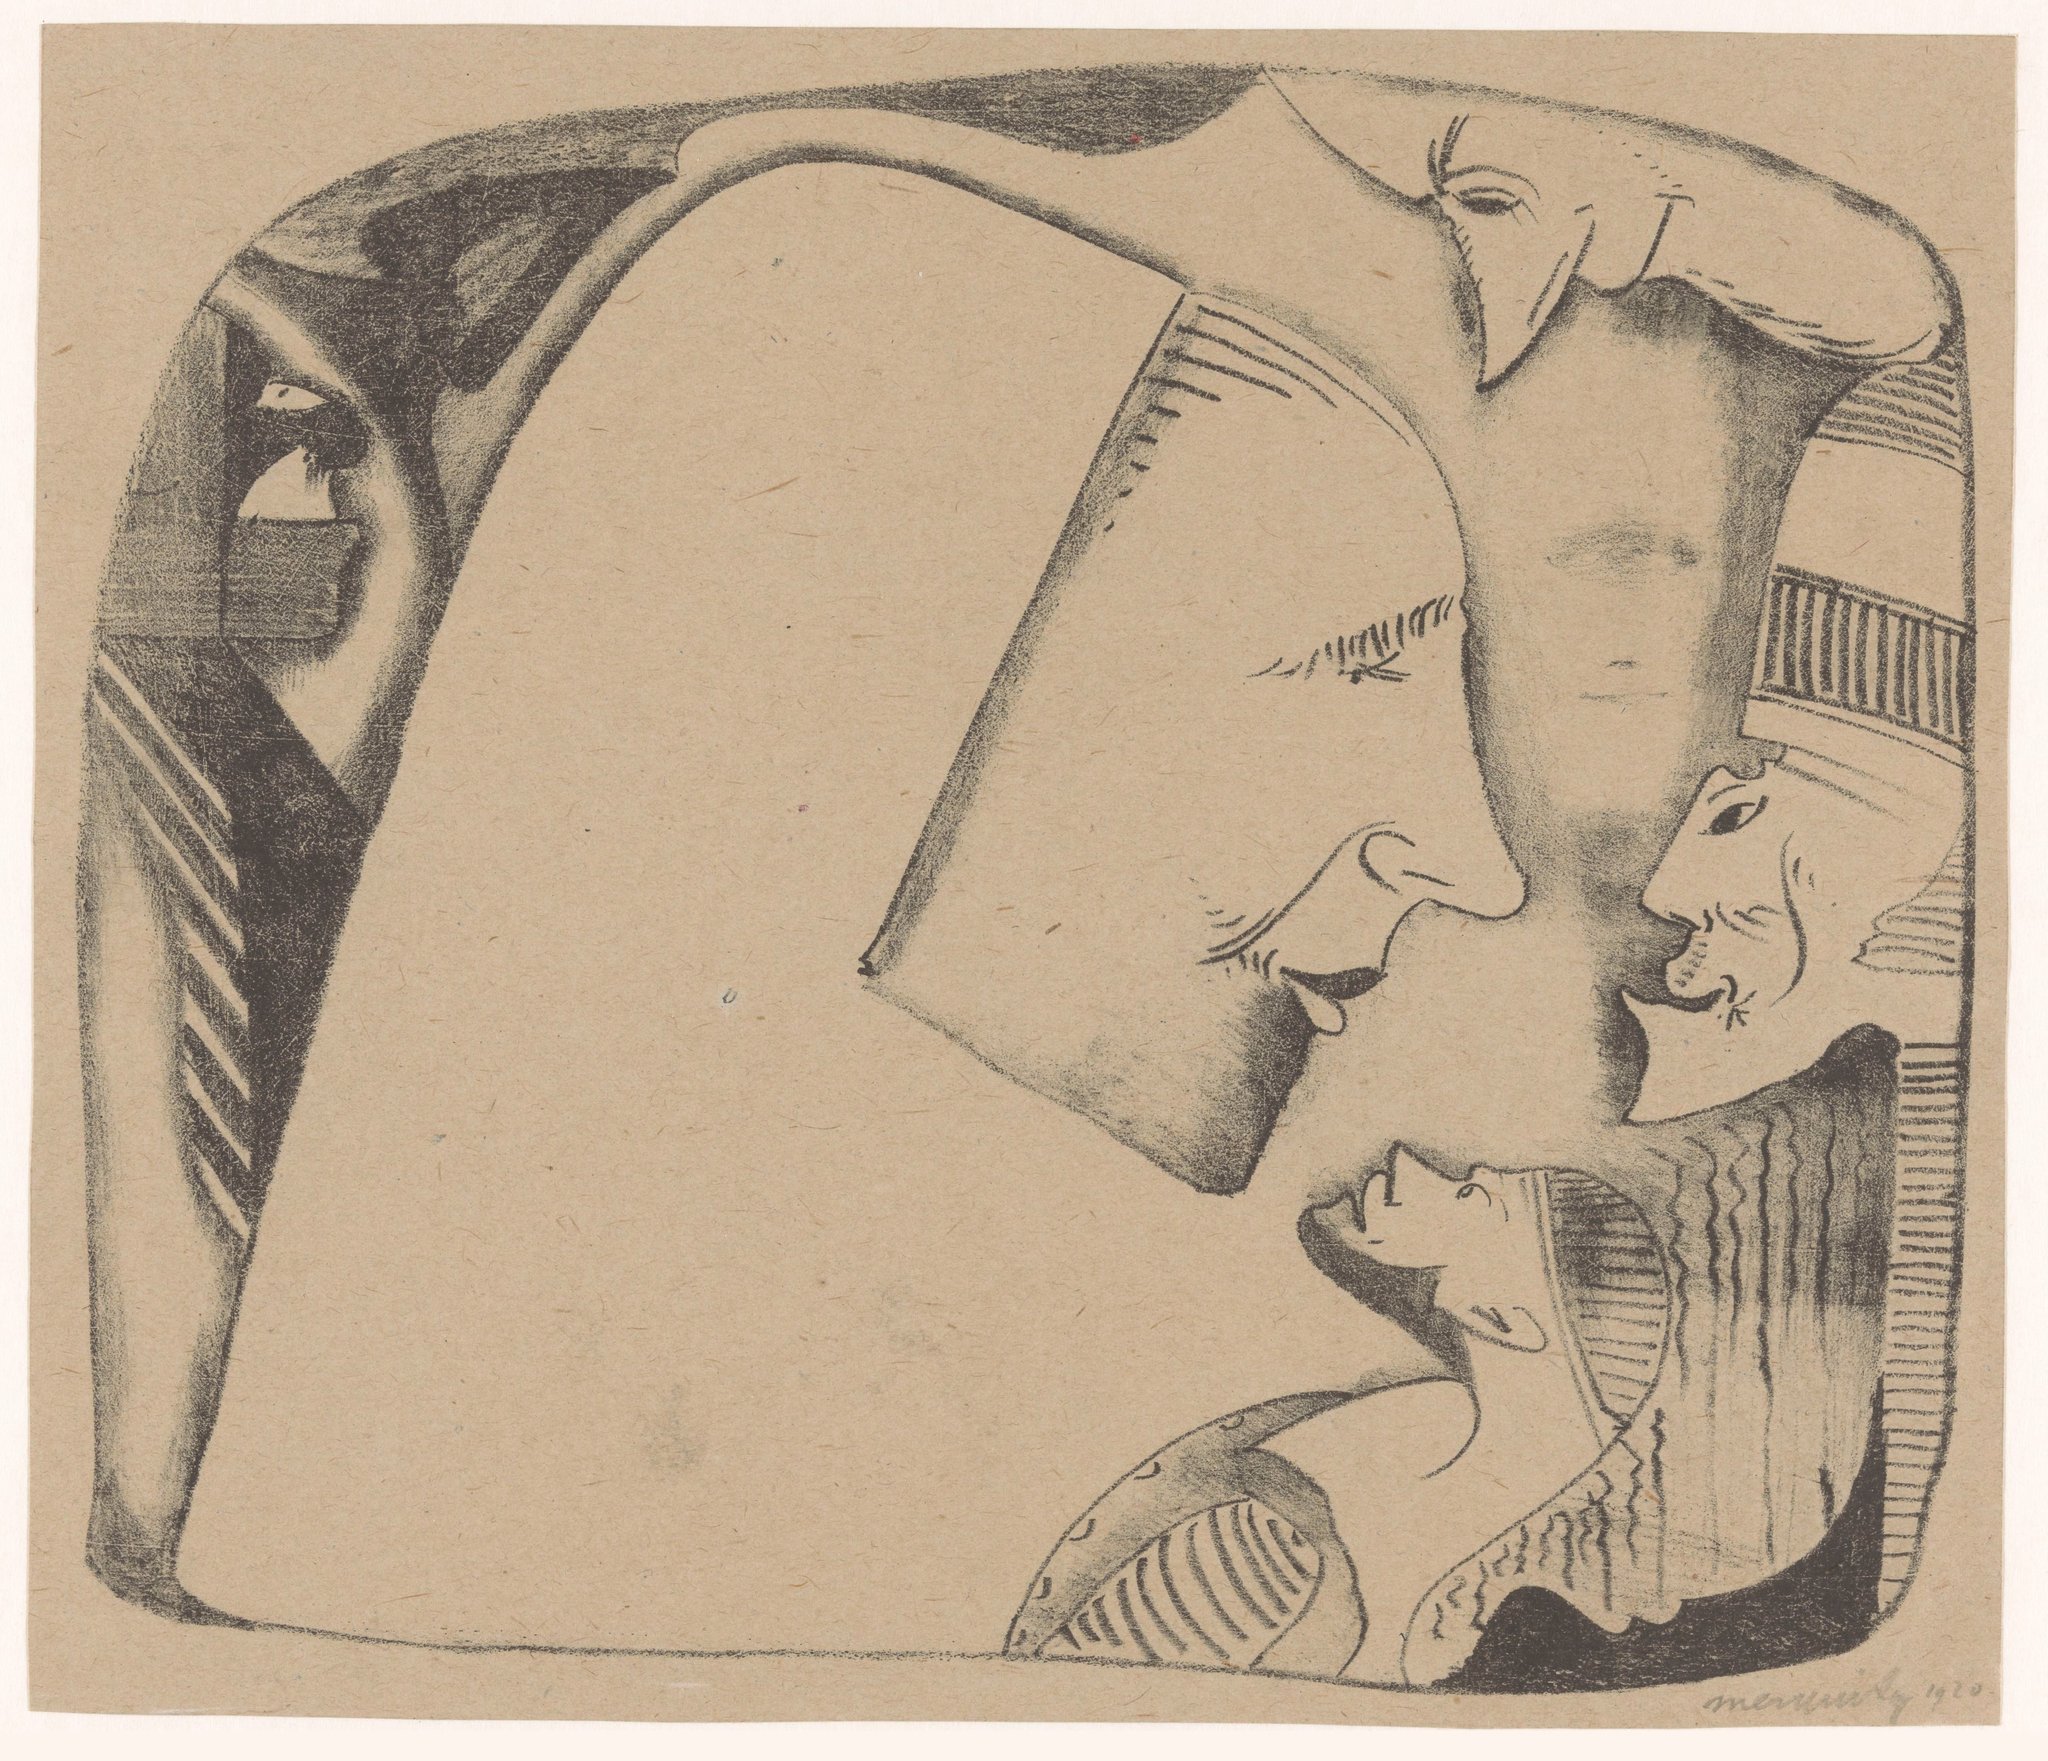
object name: print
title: Die fantasiën, waarvan één in twee staten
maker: samuel jessurun de mesquita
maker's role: draughtsman, print maker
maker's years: 1868-1944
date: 1920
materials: paper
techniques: lithograph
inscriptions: signature and date: ‘mesquita 1920’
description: Diverse profielen, in het midden een grote kop met 'lege' kap, naar rechts gewend.